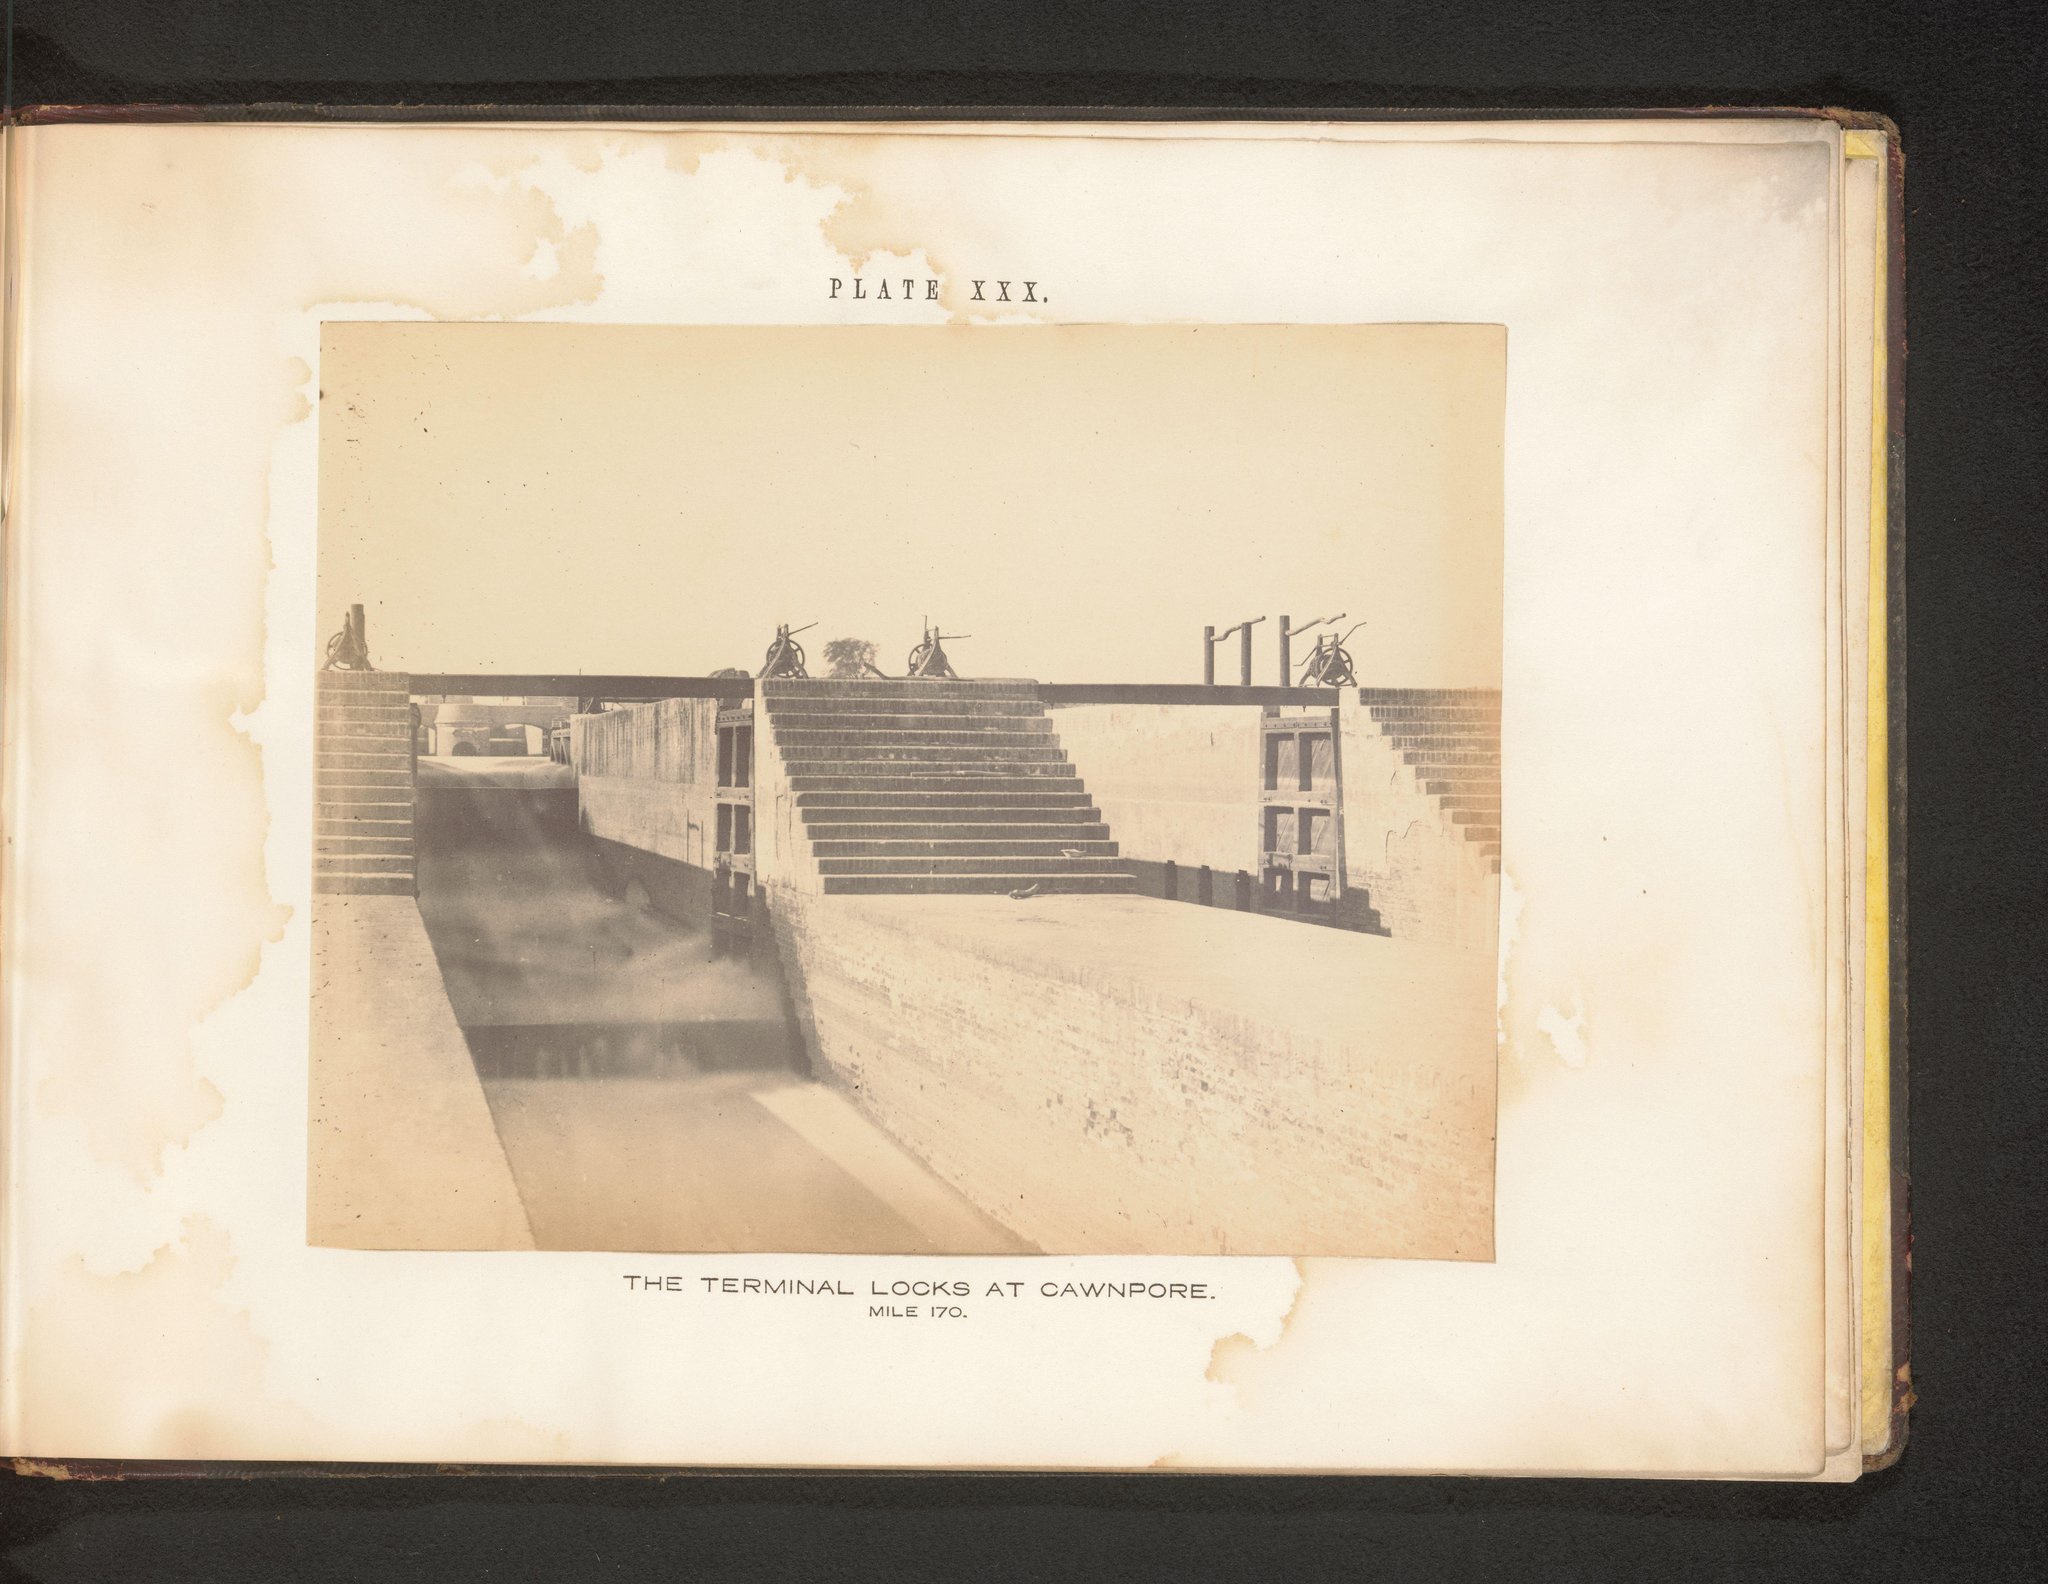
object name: page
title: The terminal locks at Cawnpore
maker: thomas george glover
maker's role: fotograaf, luitenant-kolonel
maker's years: 1825-1881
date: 1862-1867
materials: photographic support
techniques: albumen print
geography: kanpur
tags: river, lift-lock, canal lock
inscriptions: inscription: ‘Plate XXX’, inscription: ‘mile 170.’